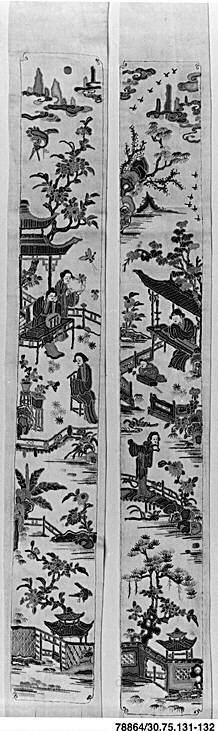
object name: sleeve band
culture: chinese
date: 1767-1800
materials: metal thread, silk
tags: birds